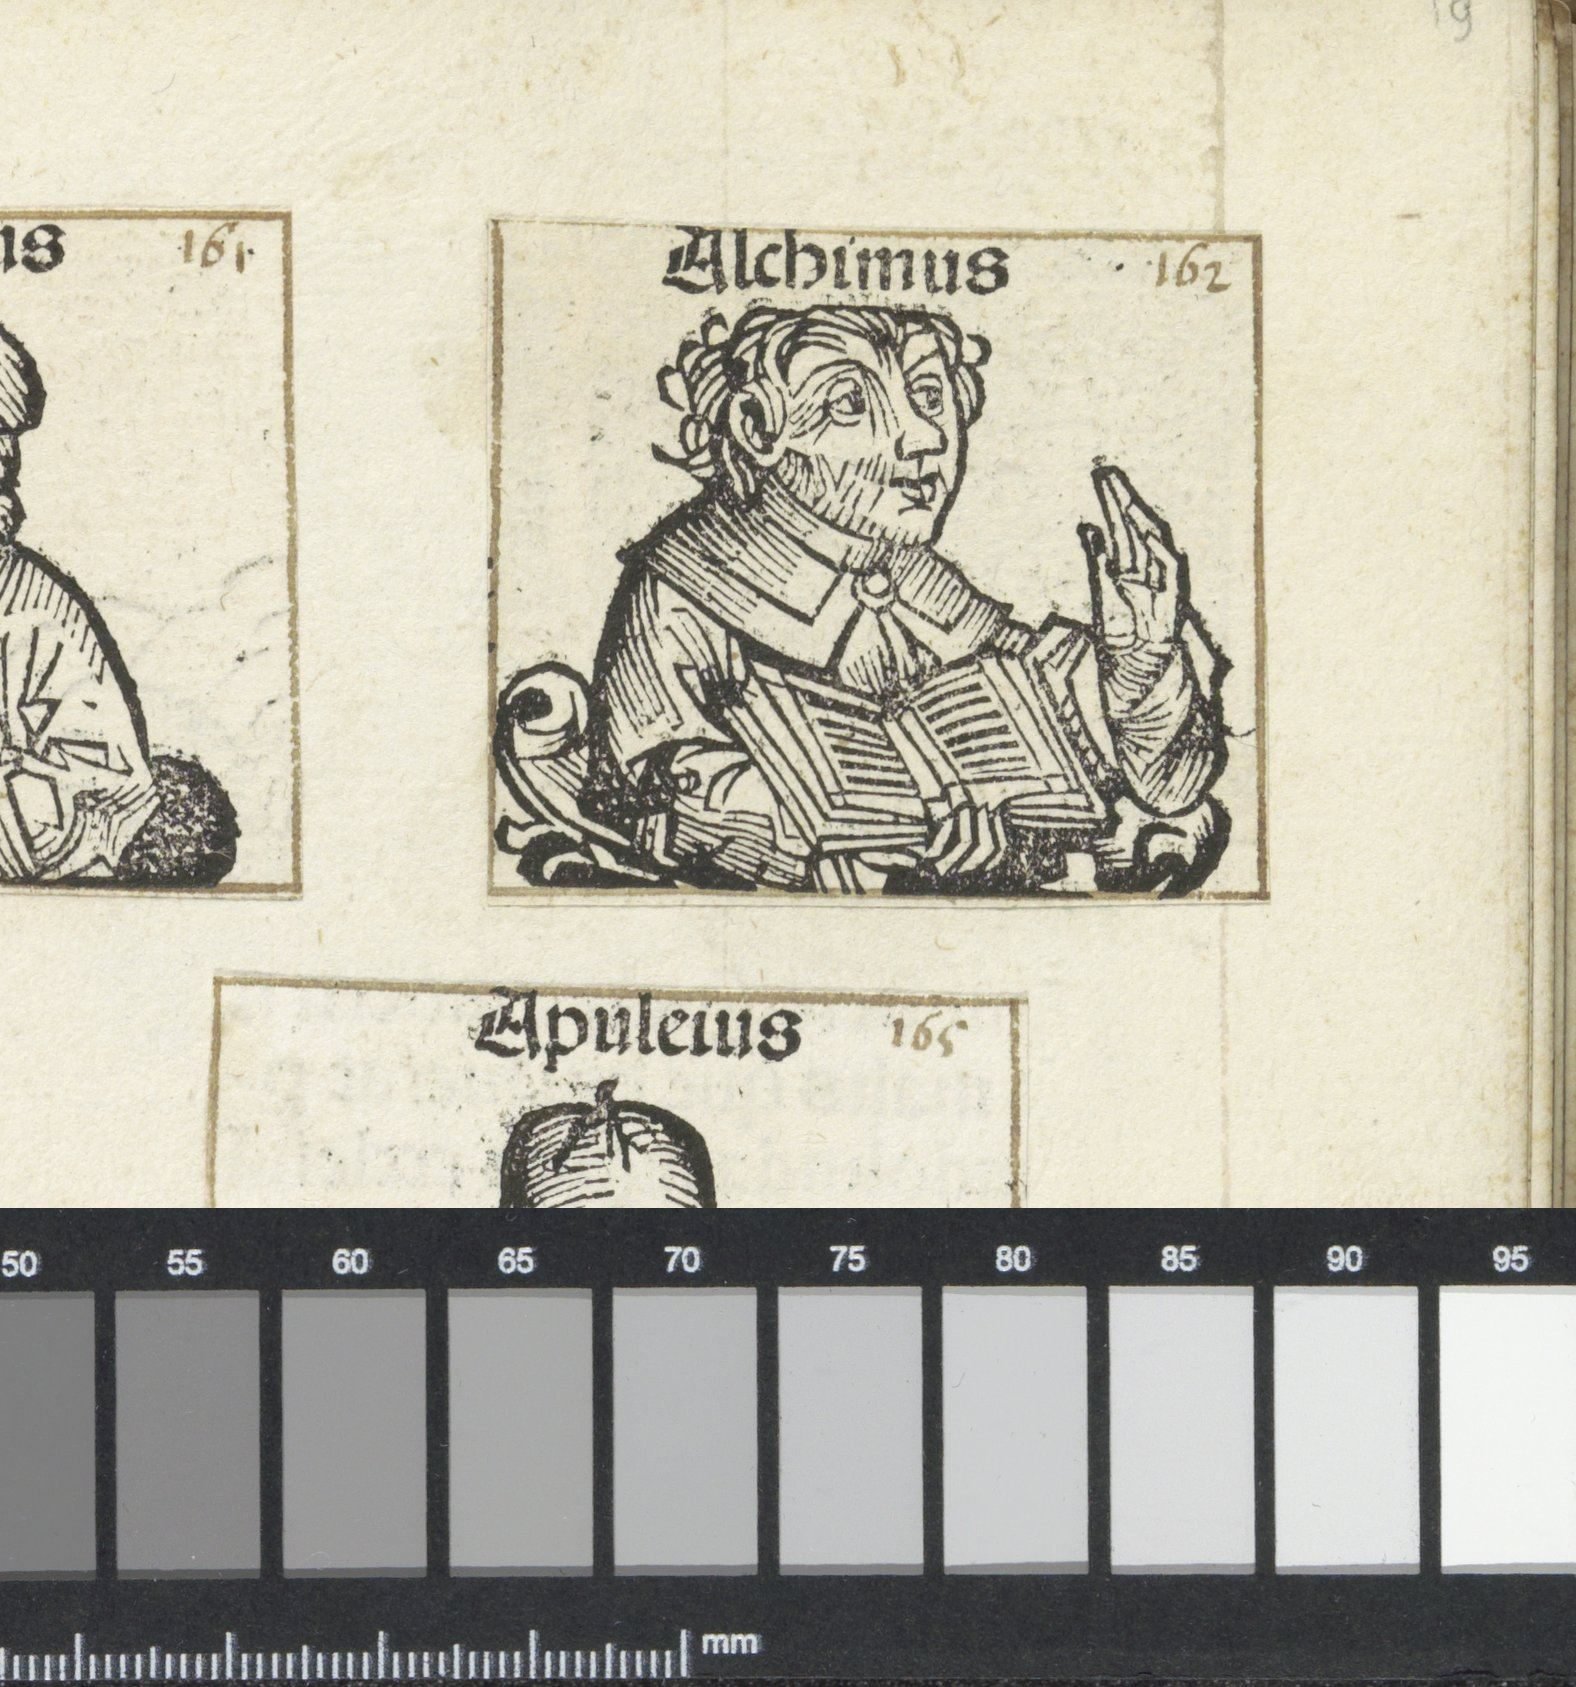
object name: print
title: Alchimus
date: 1493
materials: paper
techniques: letterpress printing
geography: nuremberg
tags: persons from the old testament (not in biblical context, nor occurring in legendary/historical extensions included in division 71)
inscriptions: inscription: ‘162’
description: De houtsnede wordt gebruikt als boekillustratie in de Liber Chronicarum (of Neurenbergkroniek) van Hartmann Schedel, verschenen in het Latijn en Duits in 1493. Zie de Latijnse uitgave, folio 77r.